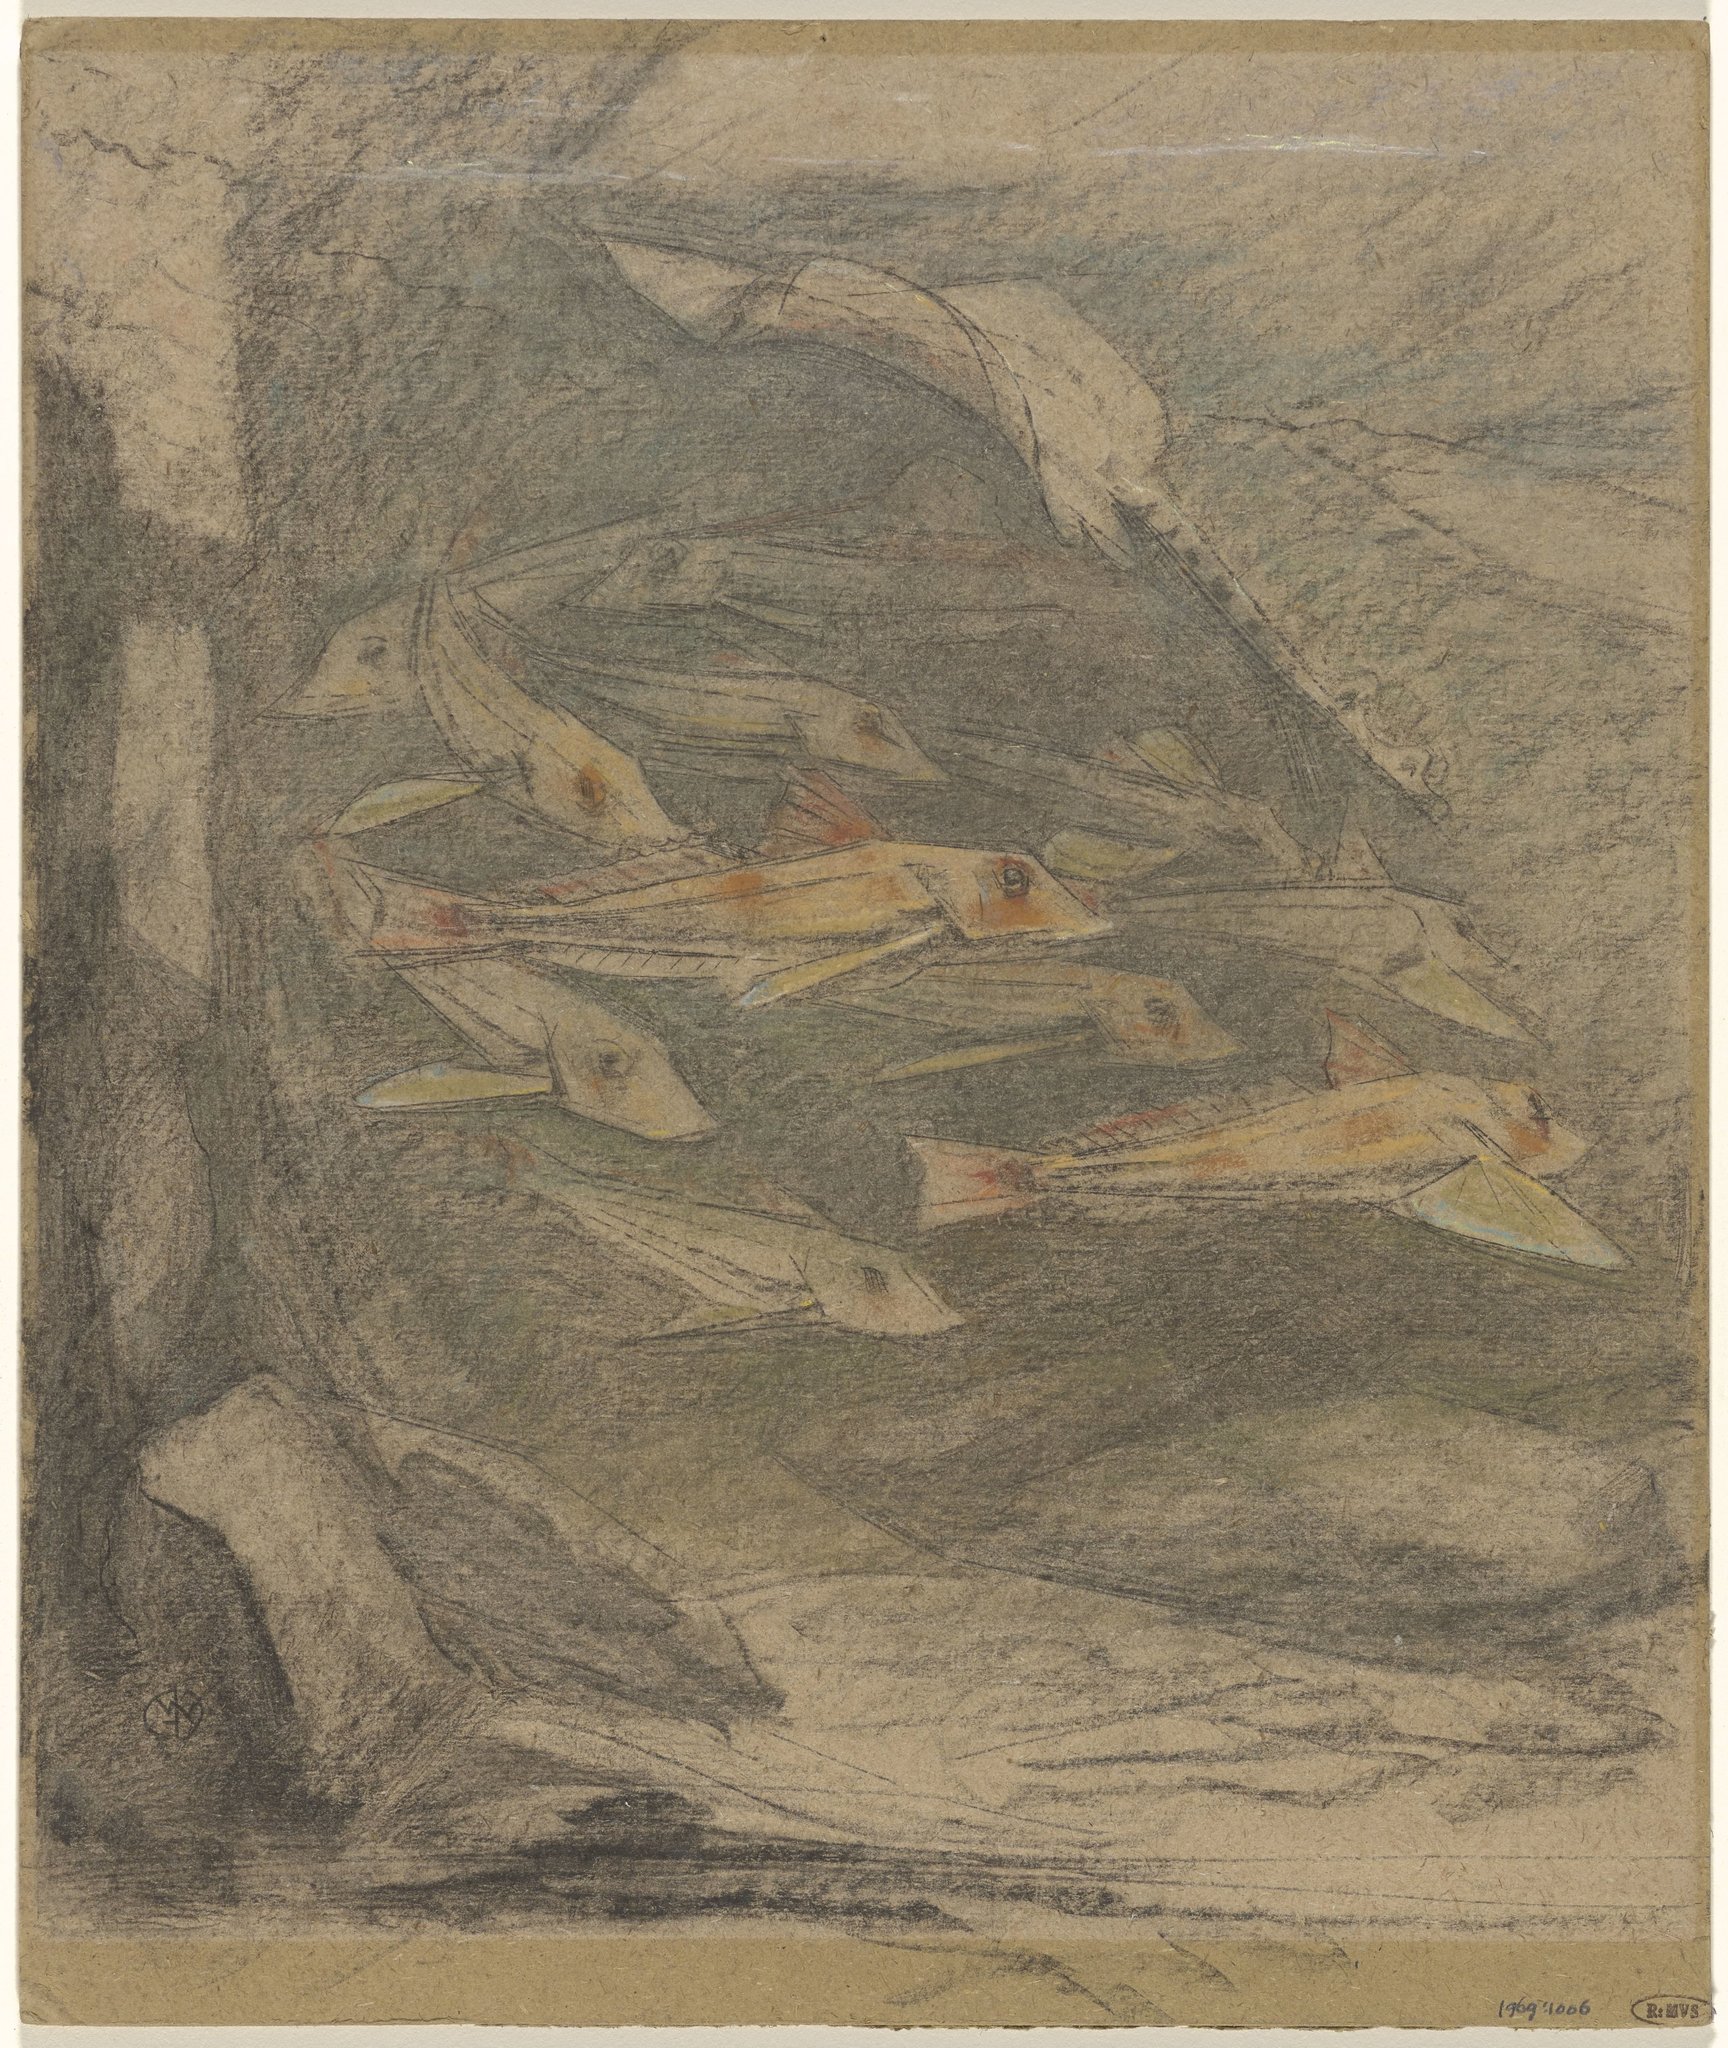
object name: drawing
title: School ponen en een rog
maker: gerrit willem dijsselhof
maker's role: designer, draughtsman, print maker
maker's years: 1866-1924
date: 1876-1924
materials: cardboard, chalk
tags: aquarium